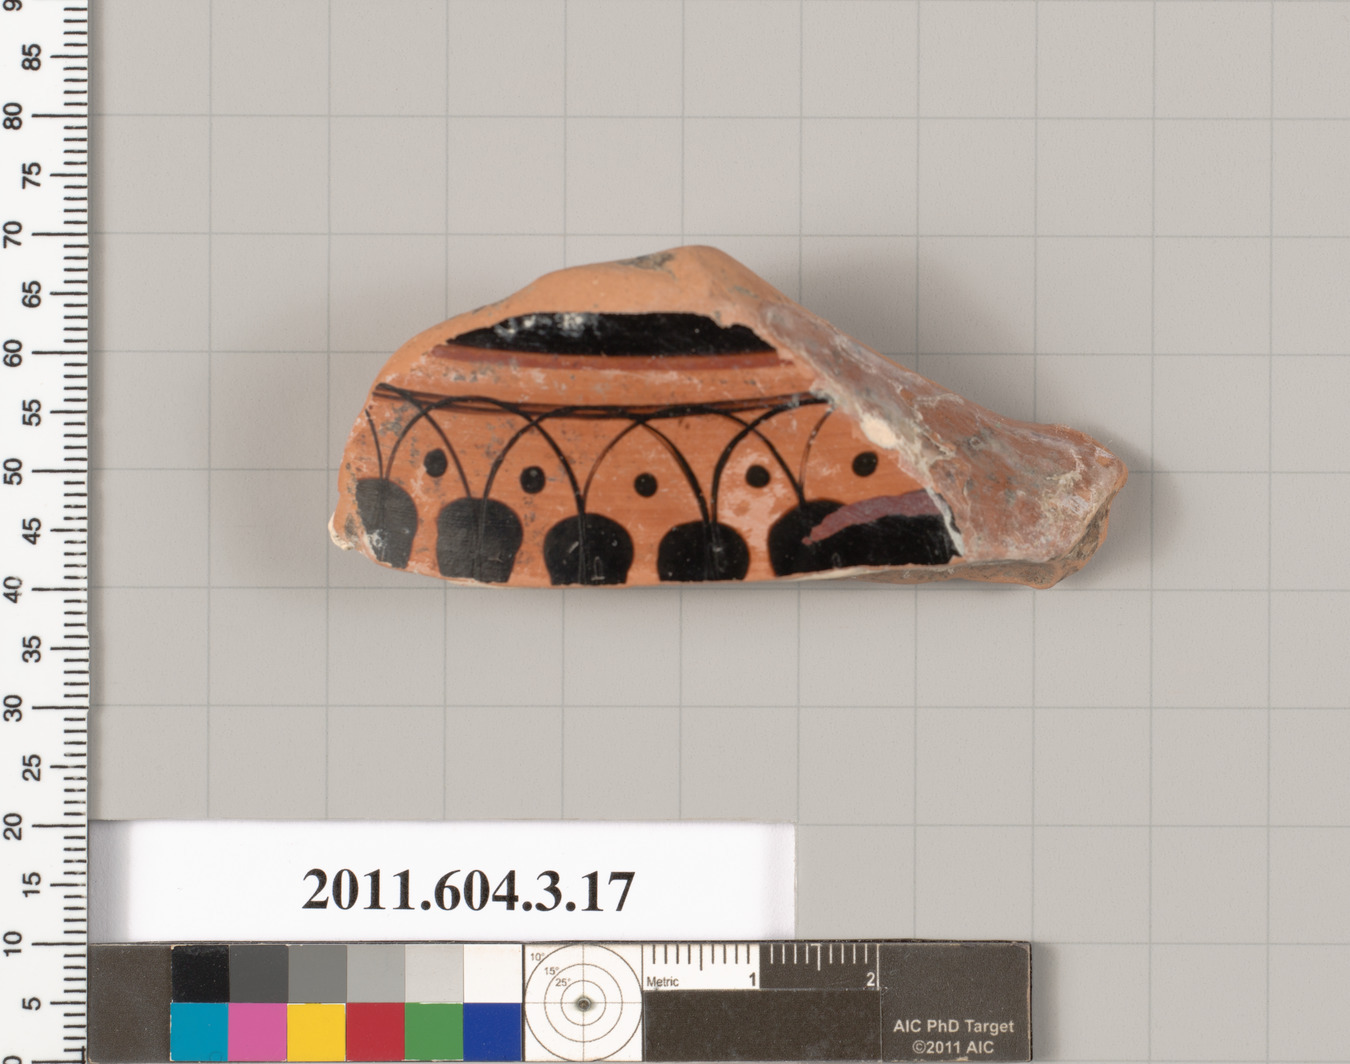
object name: pelike fragment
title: Terracotta fragment of a pelike (jar)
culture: greek, attic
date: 534-468 BCE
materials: terracotta